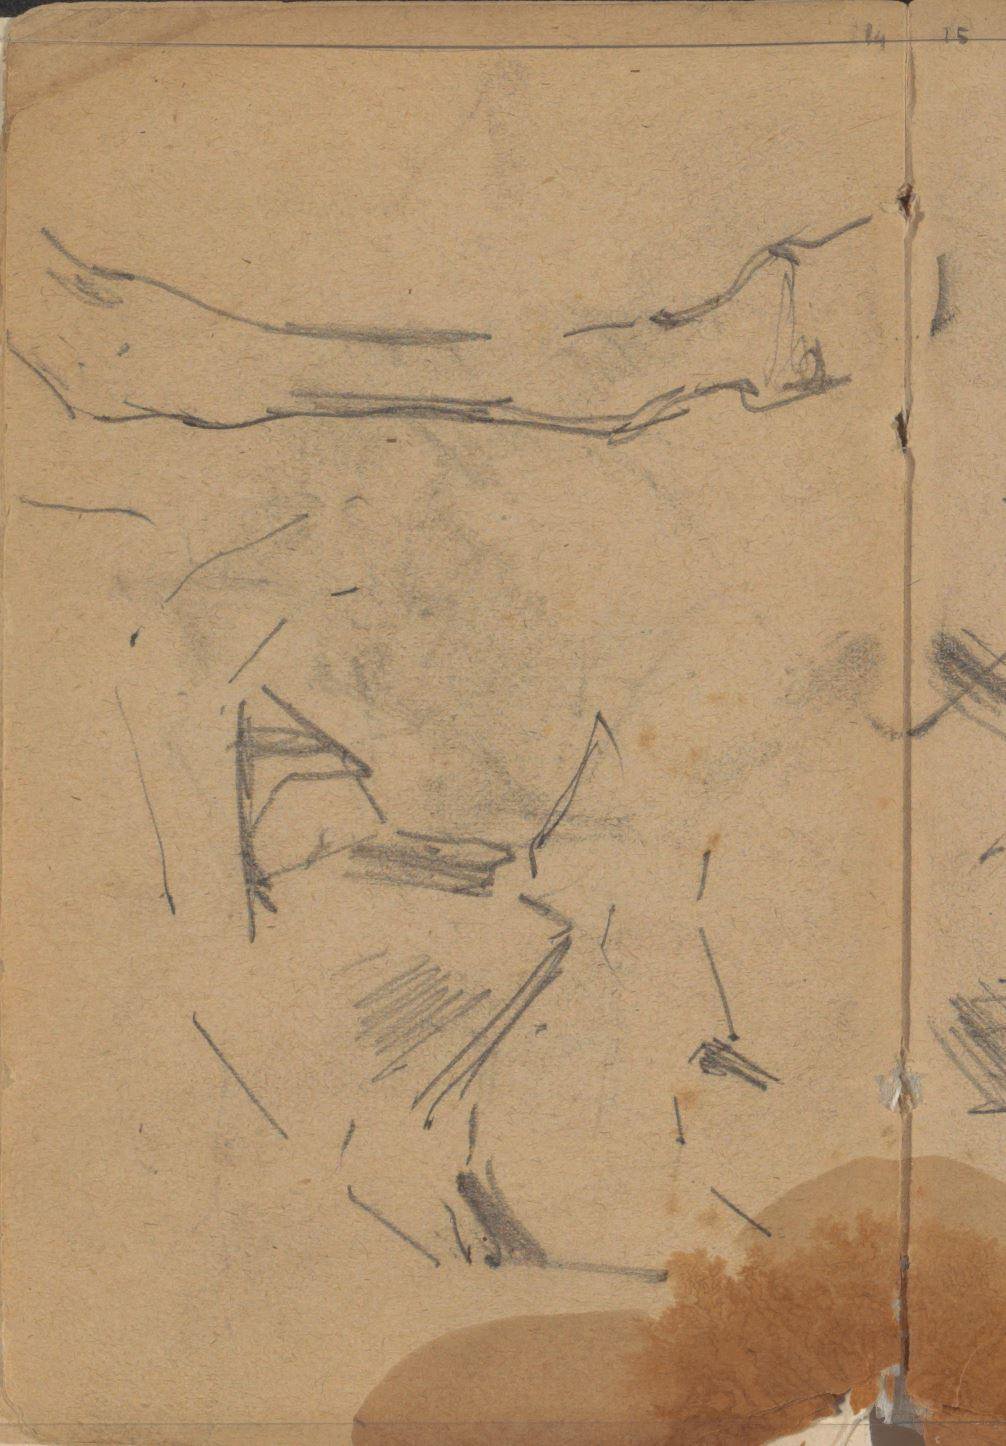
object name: sketchbook leaf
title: Paardenstudies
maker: george hendrik breitner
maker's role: draughtsman, painter, print maker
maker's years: 1857-1923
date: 1881-1883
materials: paper, pencil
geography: south holland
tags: horse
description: Paardenstudies. Pagina 14 uit een schetsboek met 70 bladen.